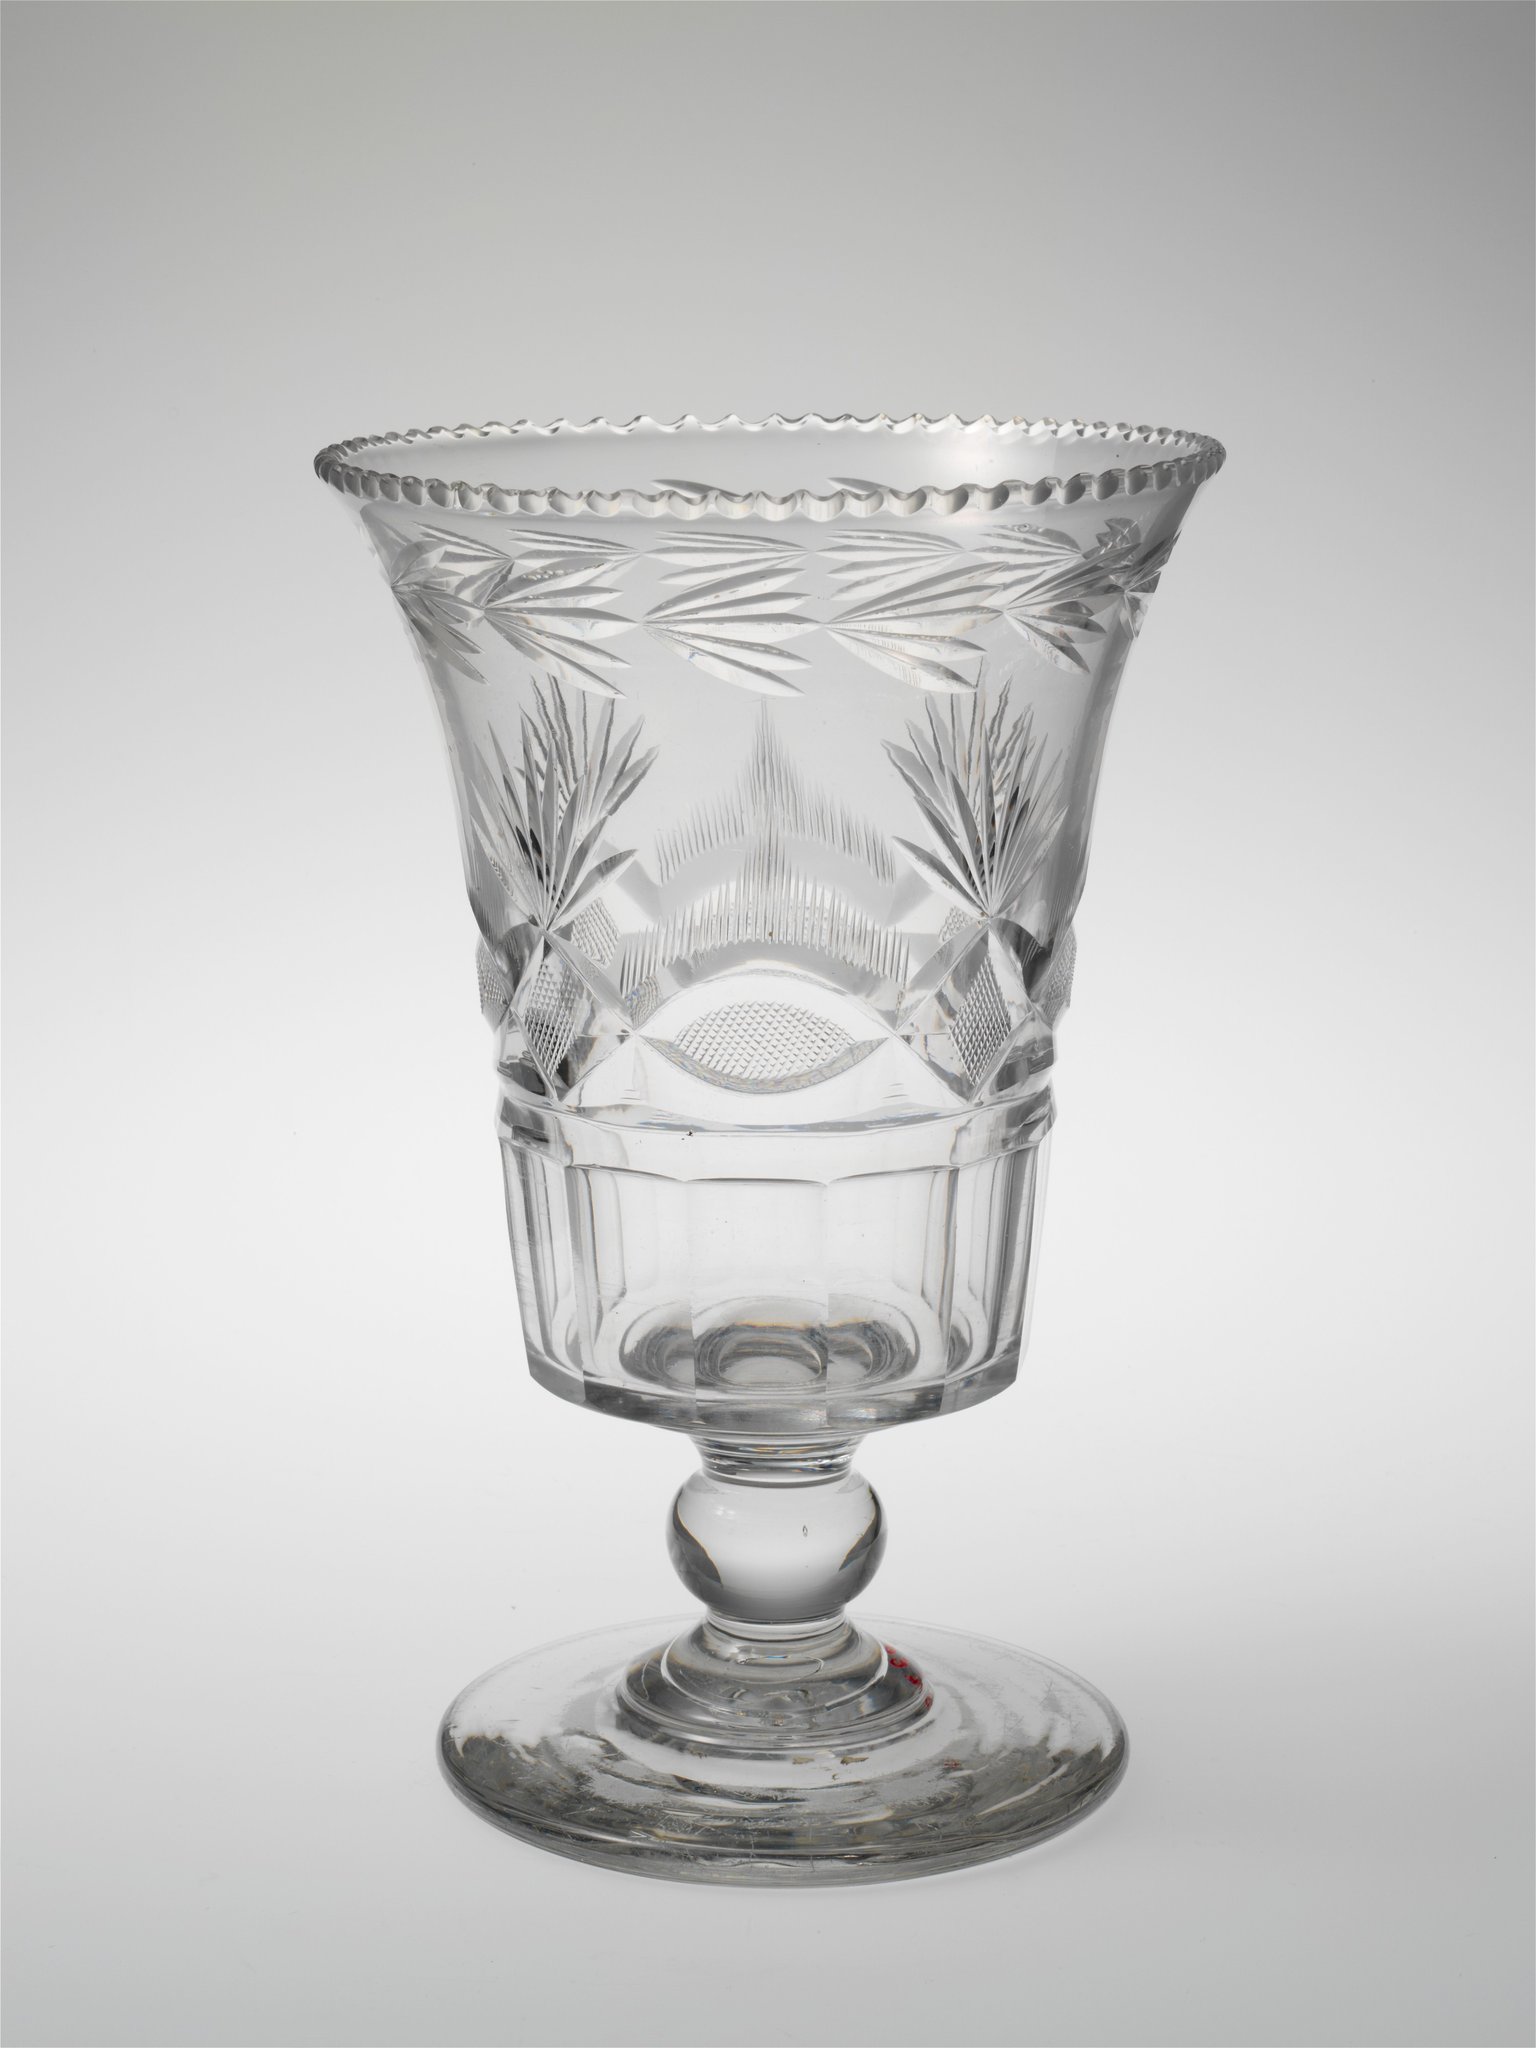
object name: celery vase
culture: american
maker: bakewell, page & bakewell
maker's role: maker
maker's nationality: american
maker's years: 1808-1882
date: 1820-1830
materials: glass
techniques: glassblowing, cutting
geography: united states